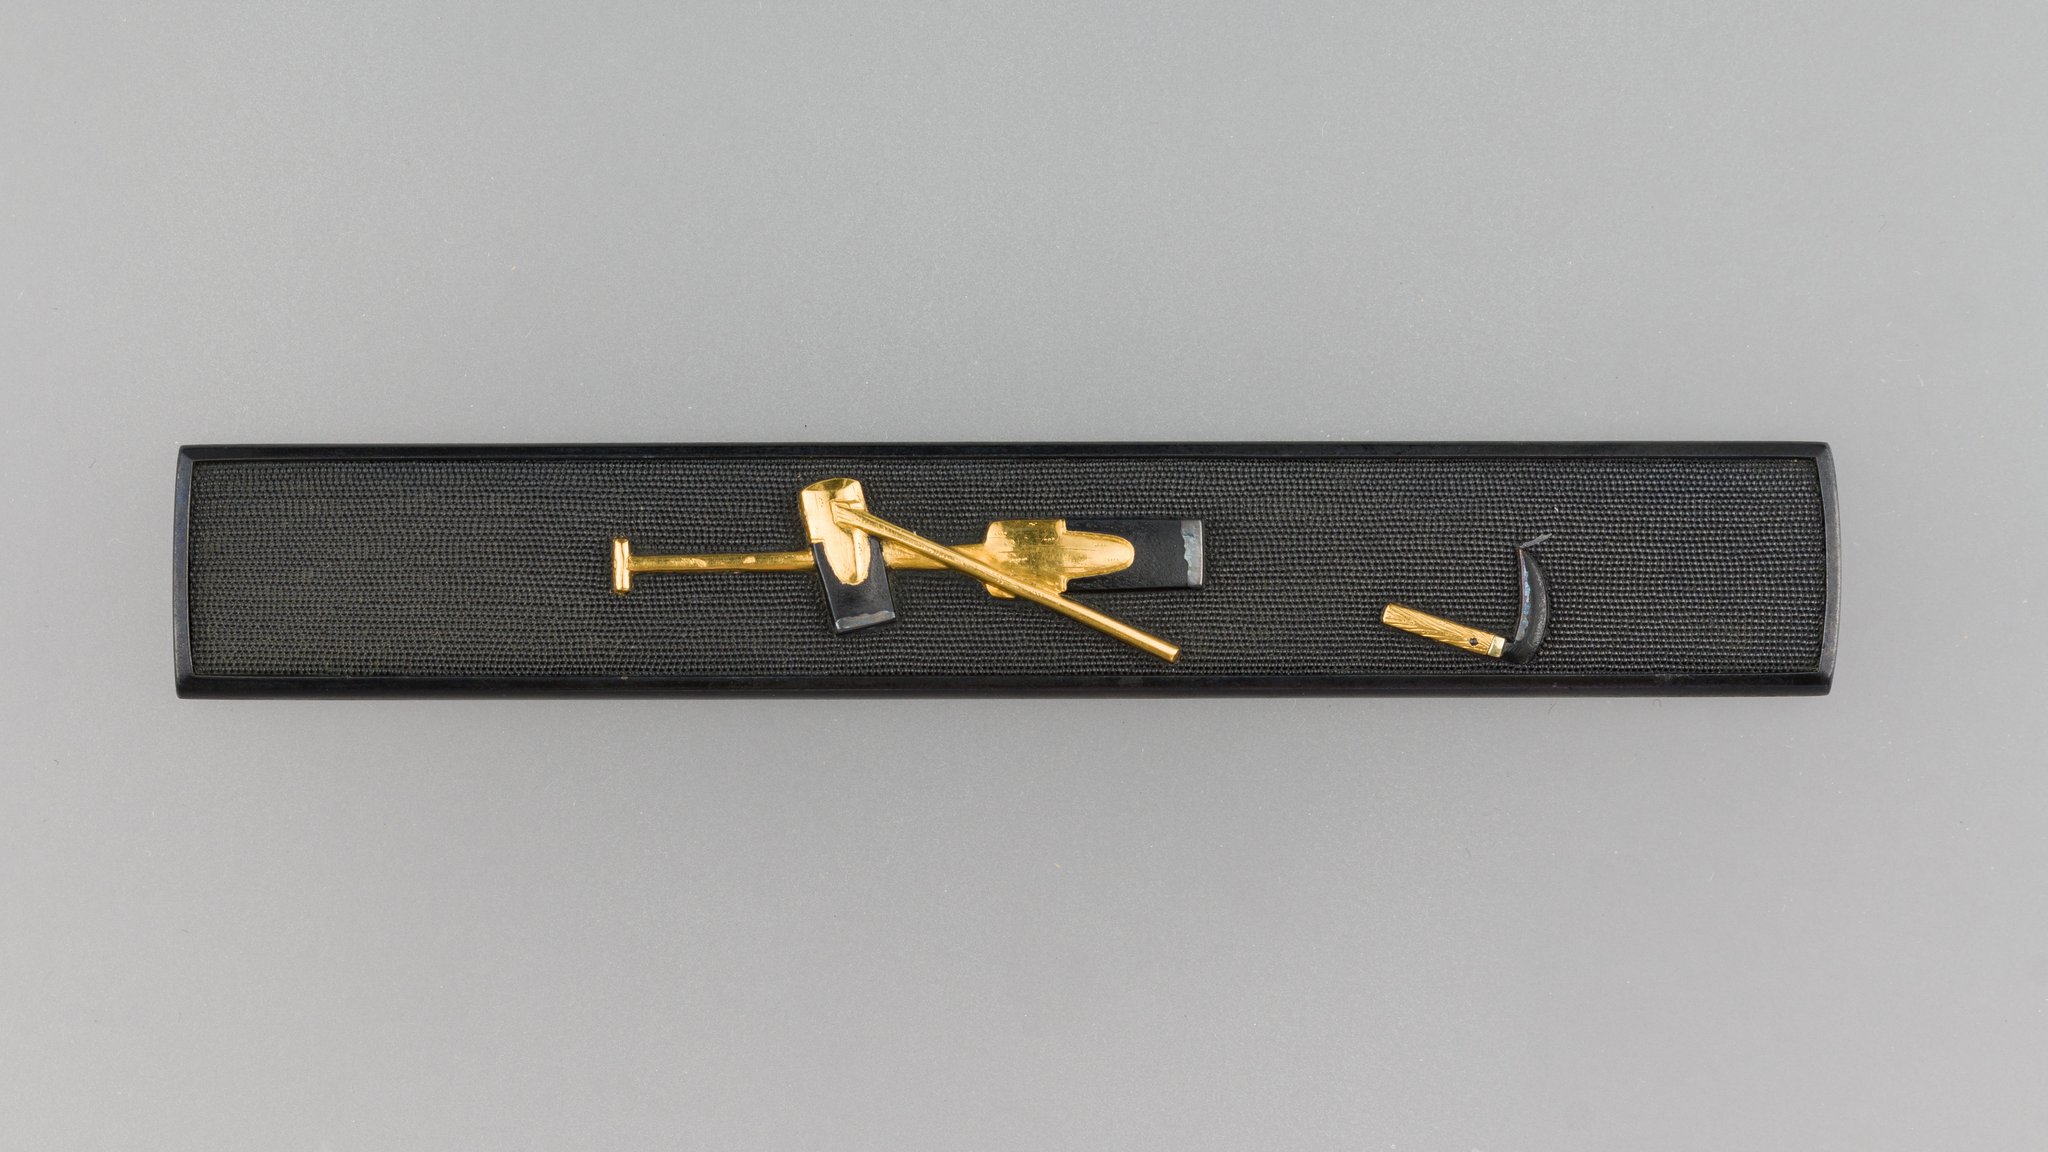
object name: knife handle kozuka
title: Knife Handle (Kozuka)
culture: japanese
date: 1834-1866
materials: gold alloy, gold, silver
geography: japan